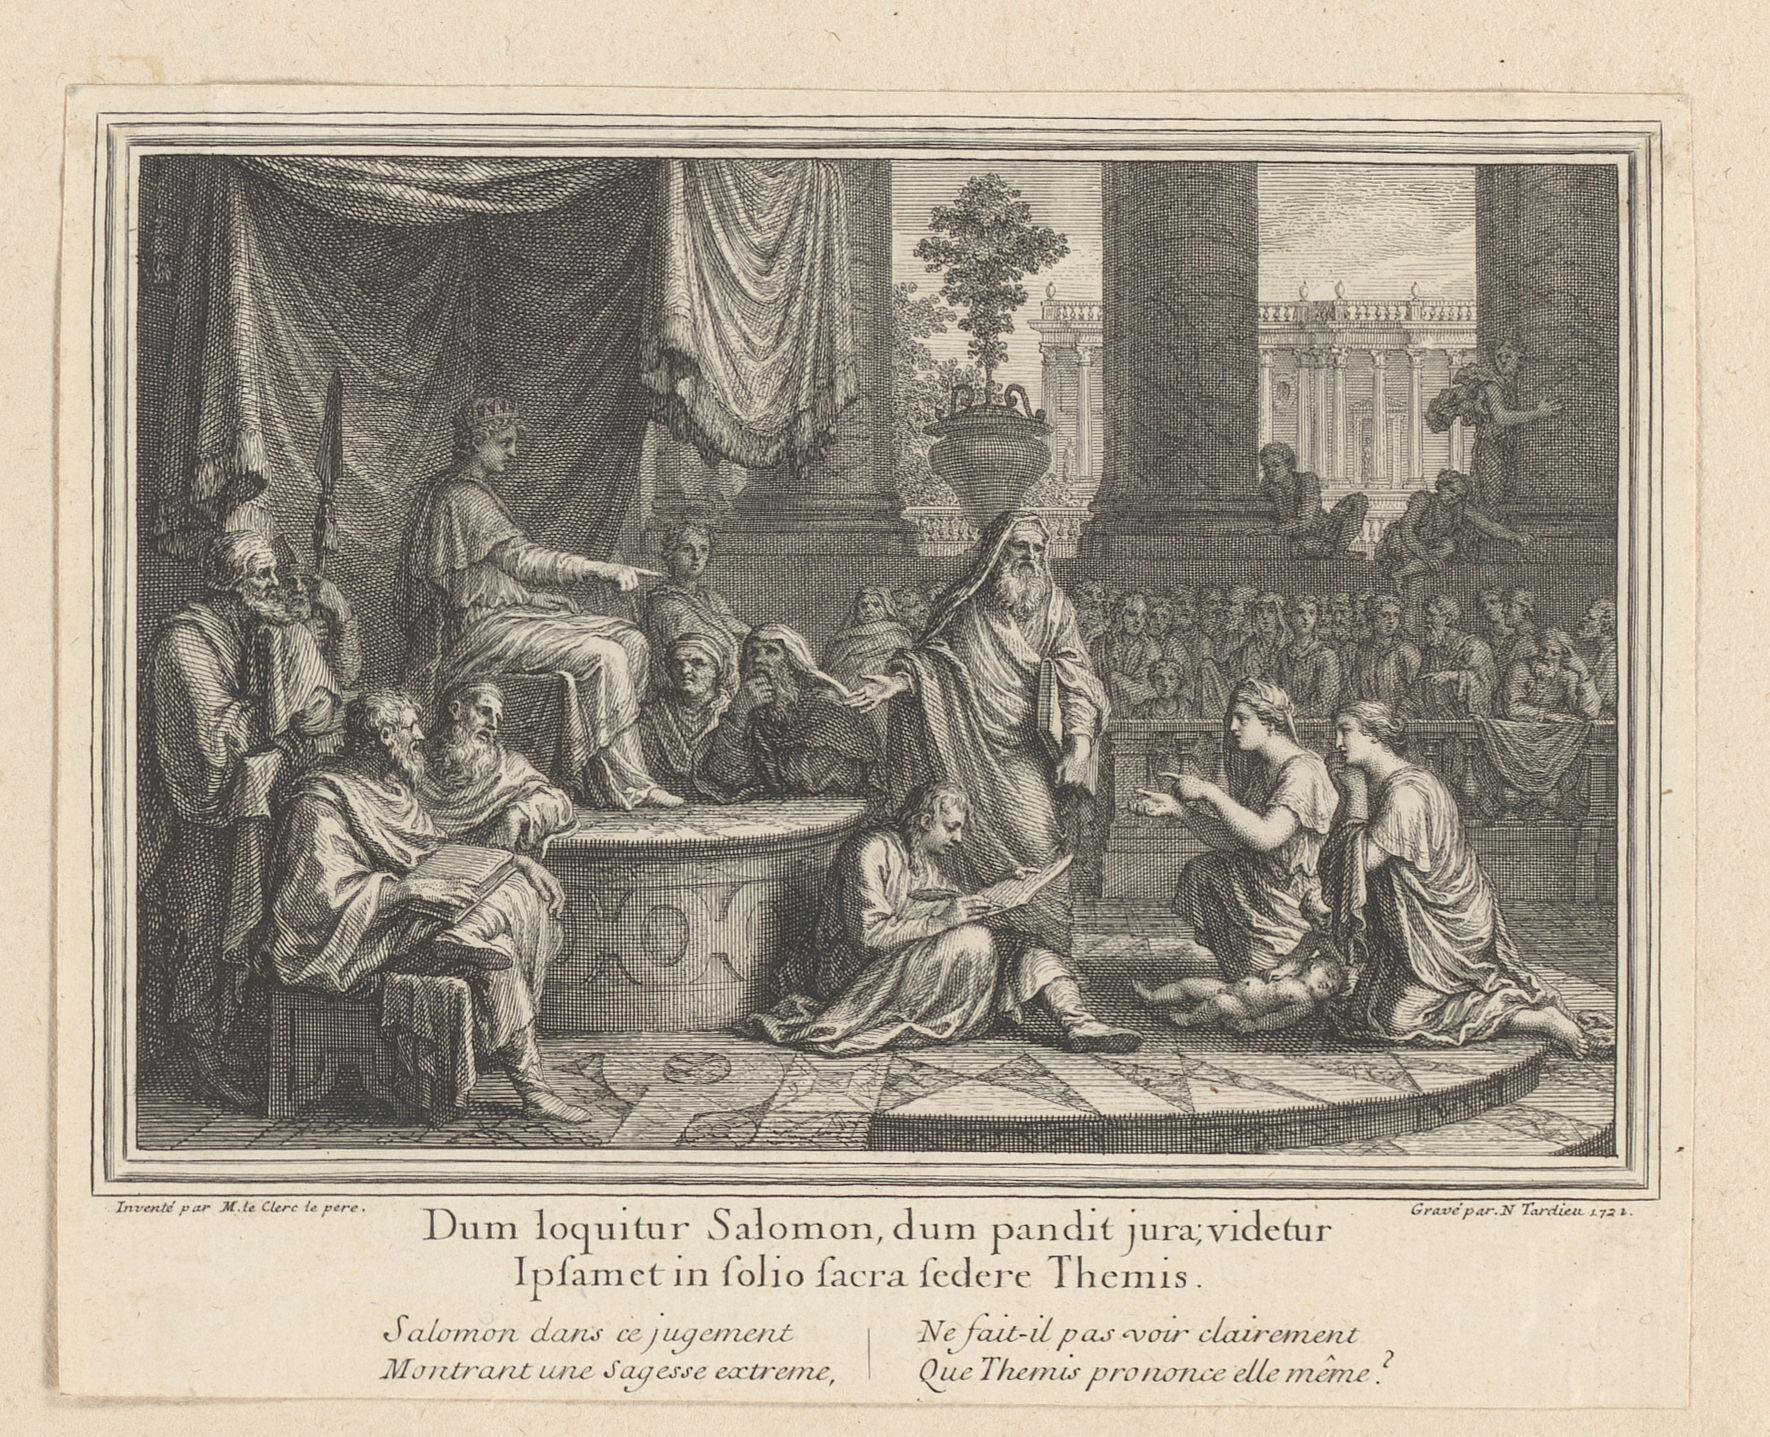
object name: print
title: Oordeel van Salomon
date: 1721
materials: paper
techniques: etching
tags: both mothers come before solomon ~ the judgement of solomon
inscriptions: date